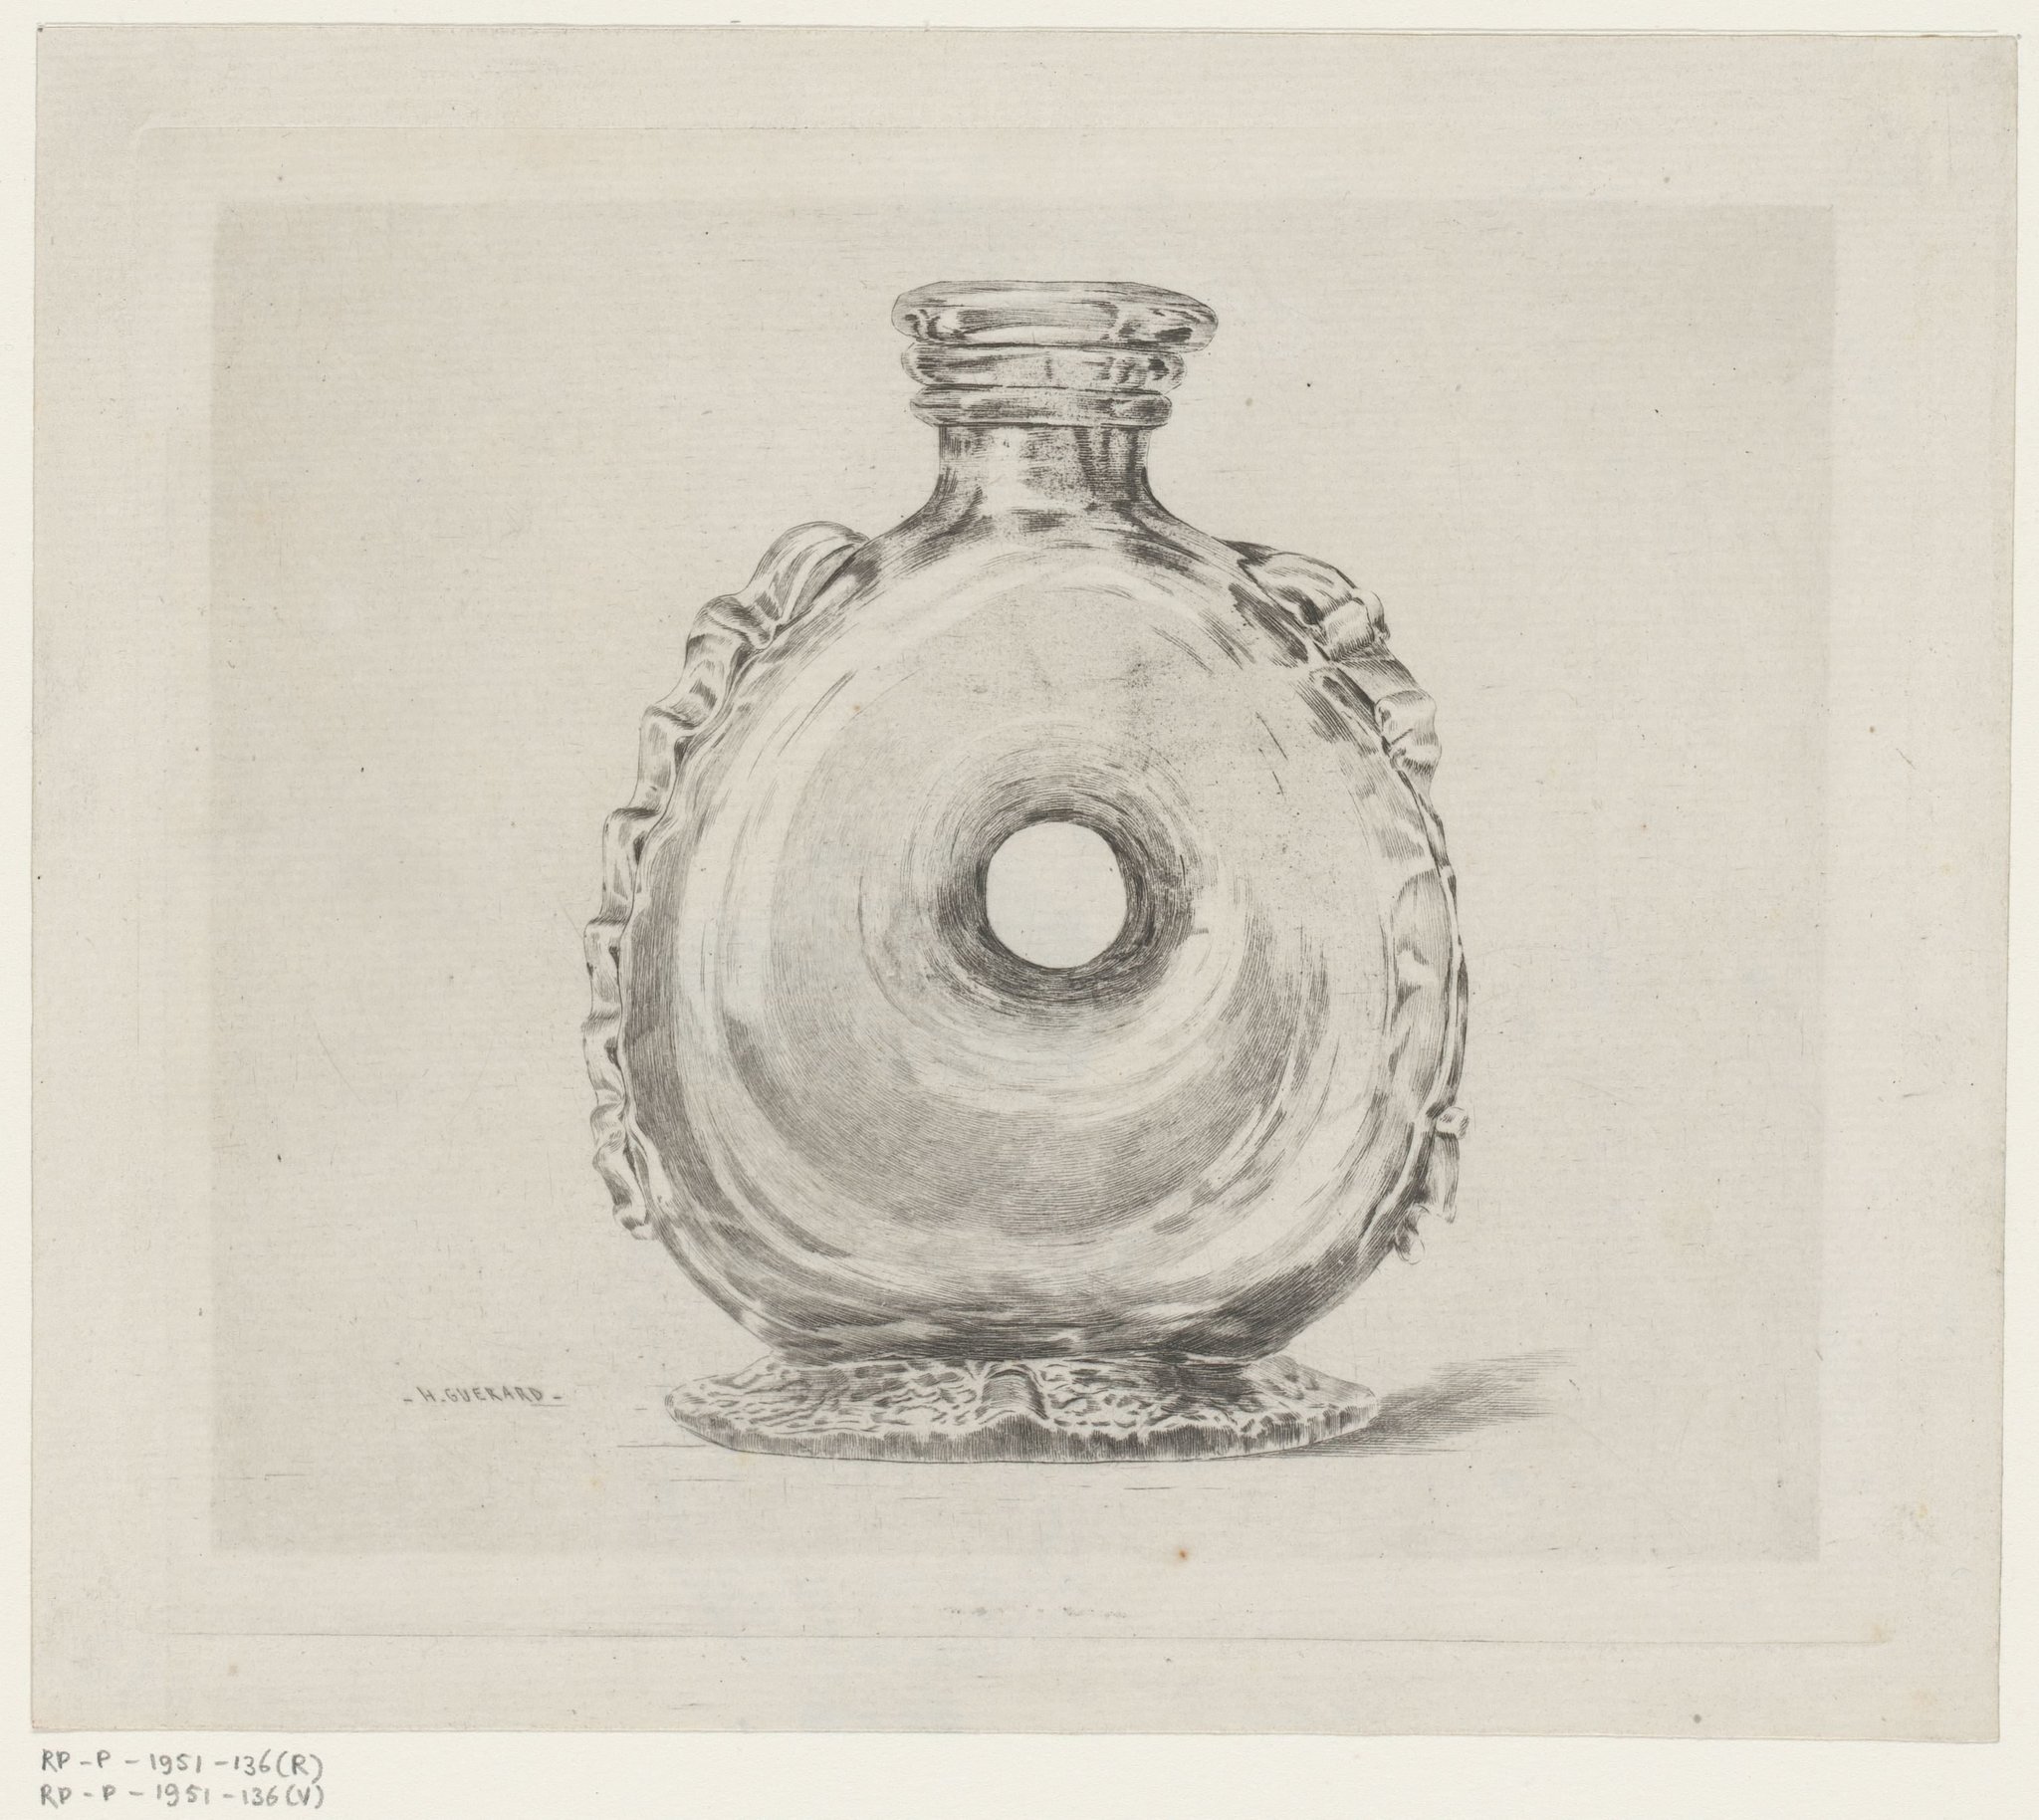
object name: print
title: Glazen vaas, mogelijk Venetiaans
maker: henri charles guérard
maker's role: print maker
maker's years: 1846-1897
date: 1856-1897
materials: paper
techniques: etching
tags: container of glass: bottle, jar, vase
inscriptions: collector's mark: Lugt 2228